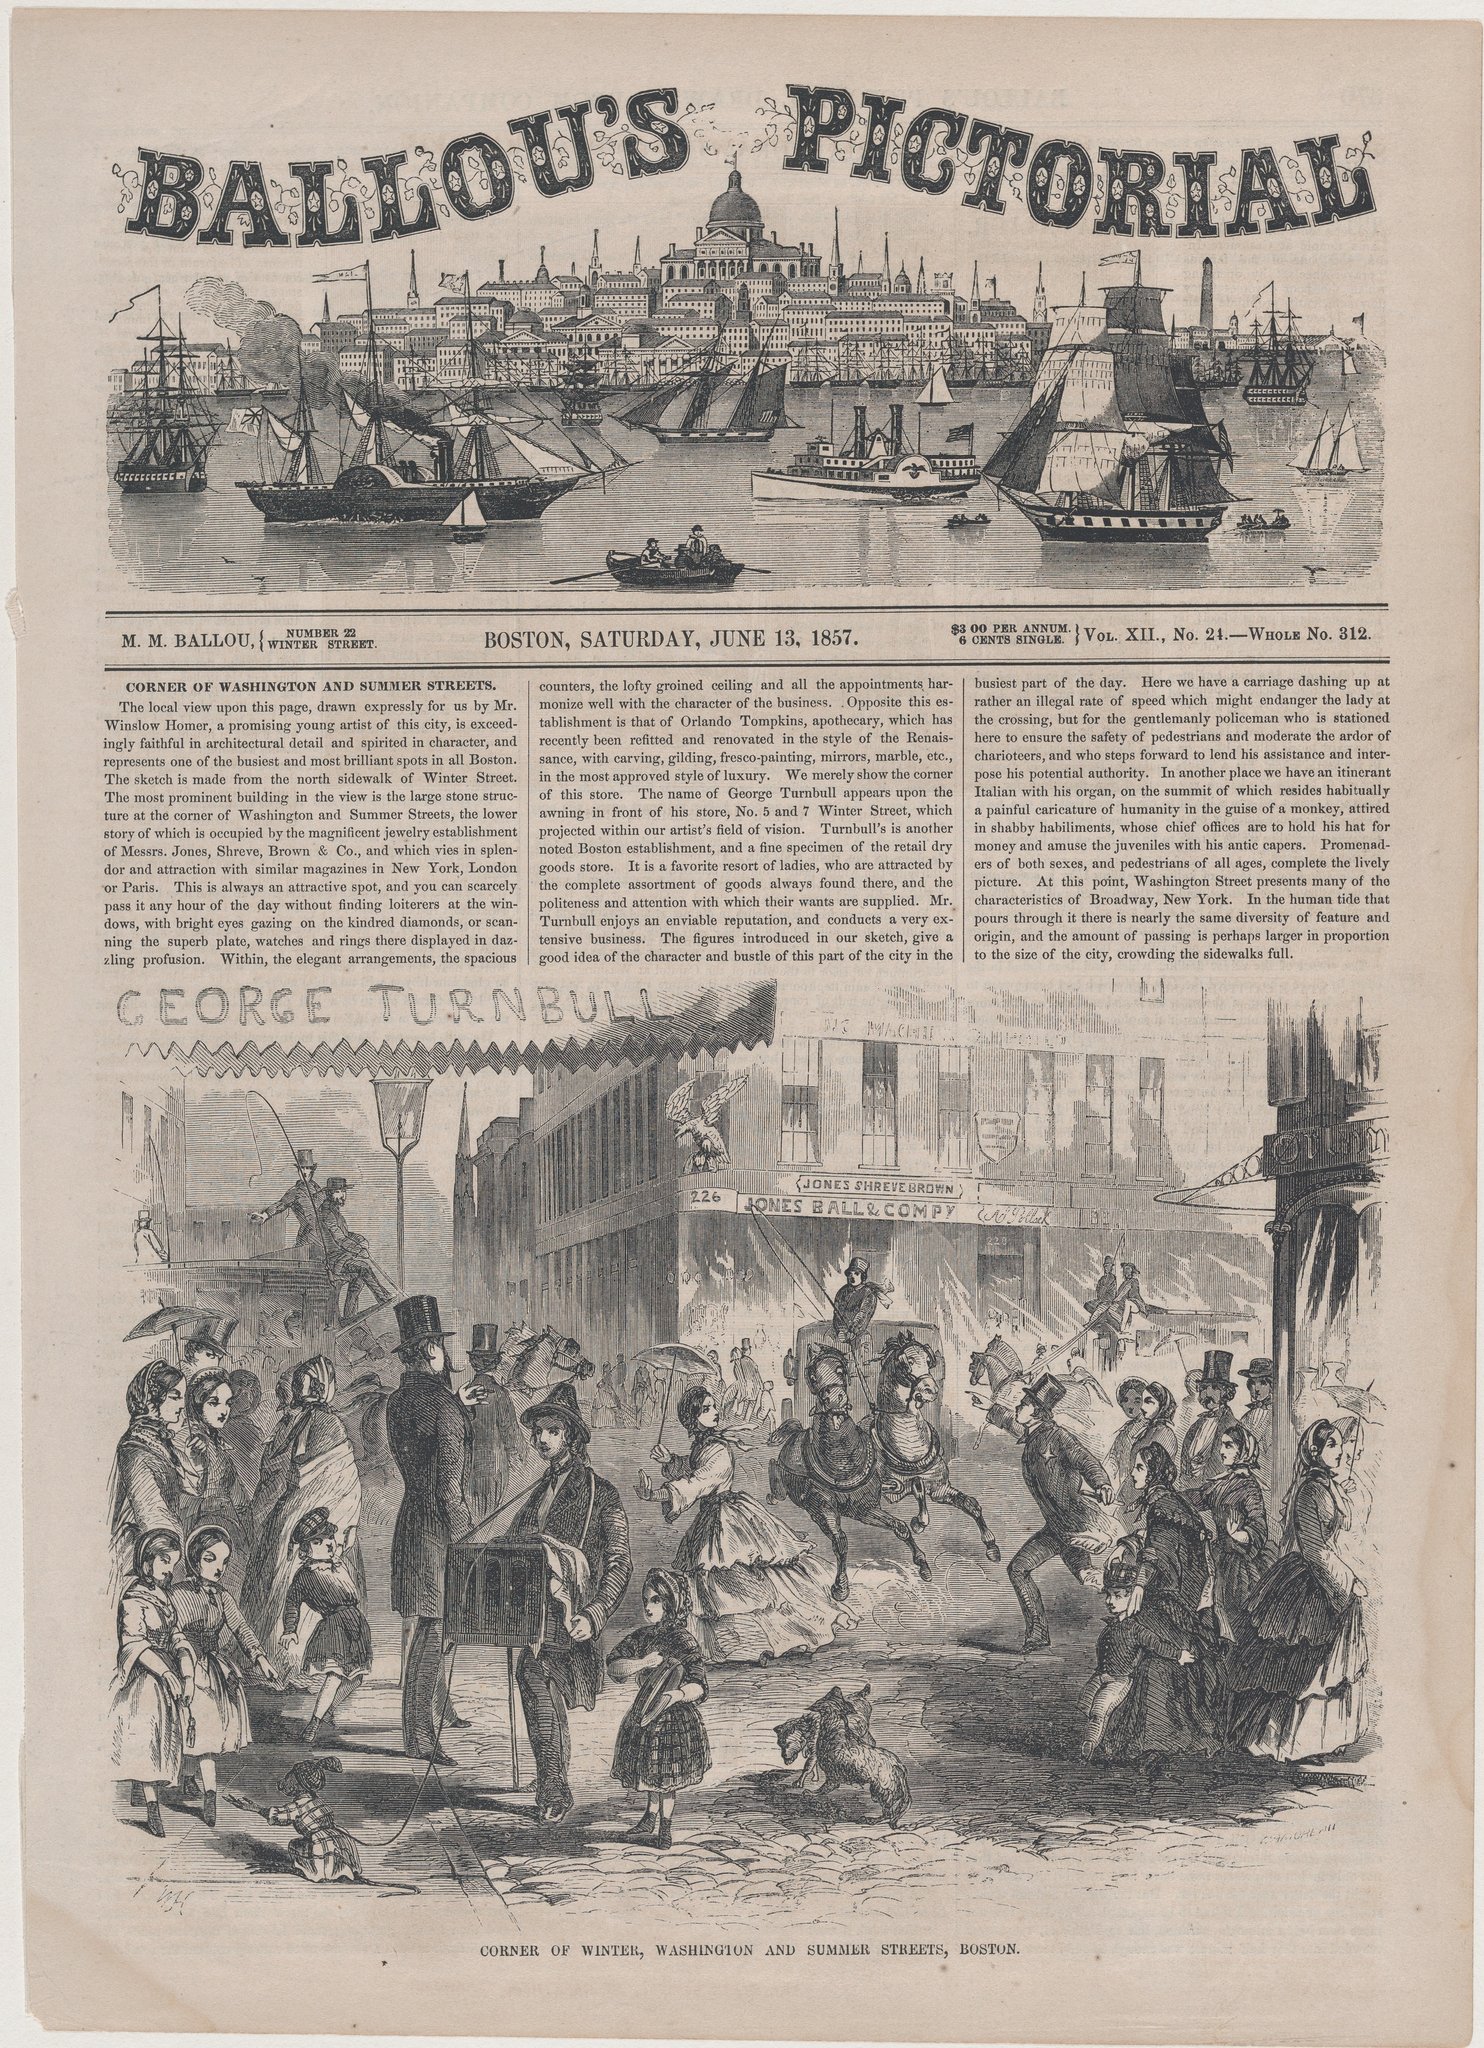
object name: print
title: Corner of Winter, Washington and Summer Streets, Boston (Ballou's Pictorial Drawing Room Companion, Vol. XII)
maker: winslow homer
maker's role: artist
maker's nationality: american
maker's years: 1836-1910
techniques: engraving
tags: winter,crowd,street scene,ships